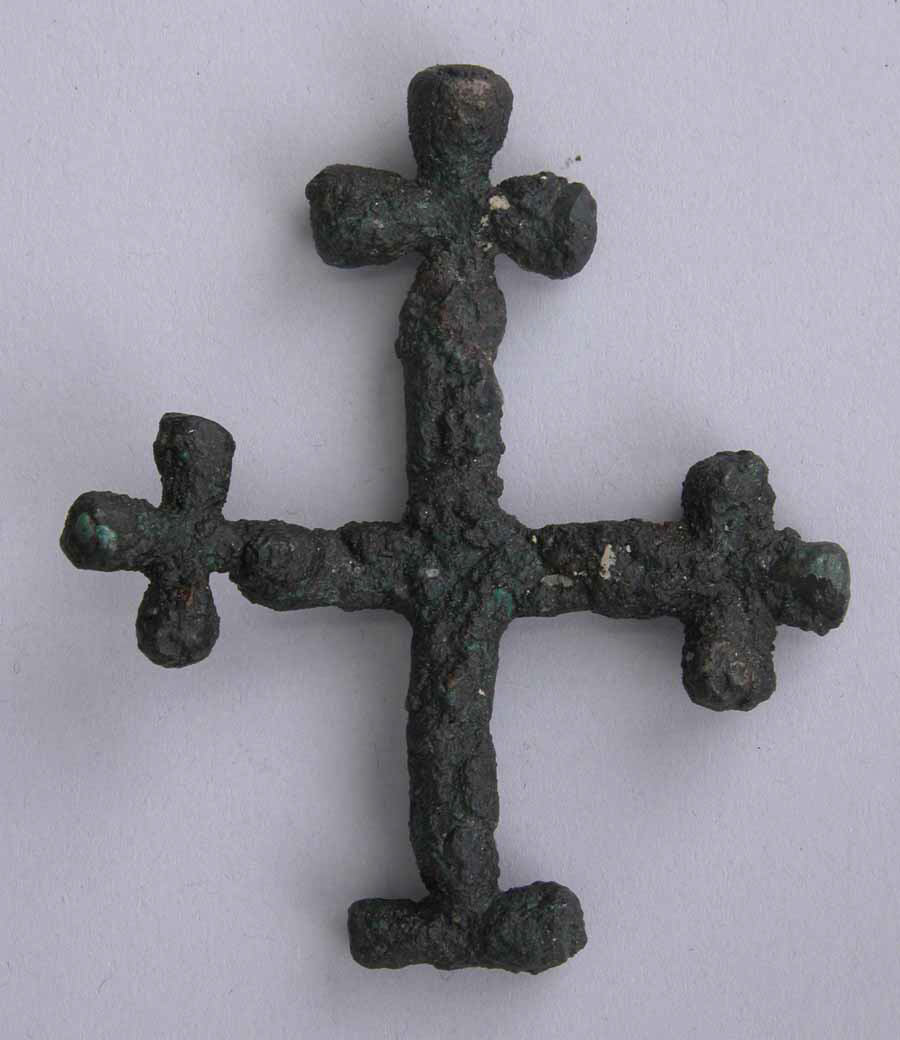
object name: cross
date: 201-1200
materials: bronze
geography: egypt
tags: cross